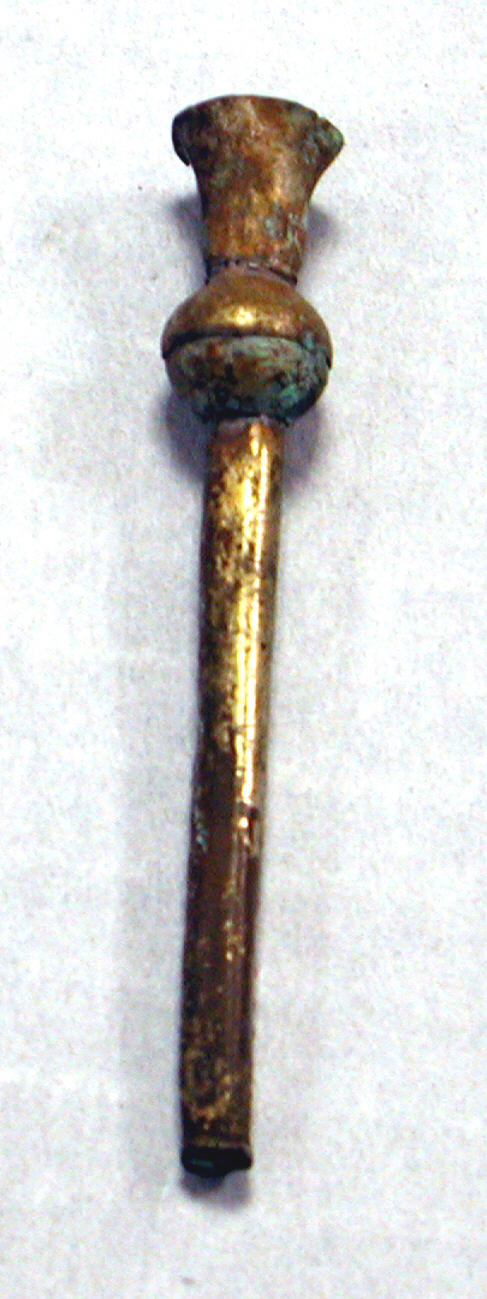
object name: scepter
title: Hammered Silver Miniature Scepter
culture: peruvian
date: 701-1566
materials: copper, gilt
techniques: hammering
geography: peru